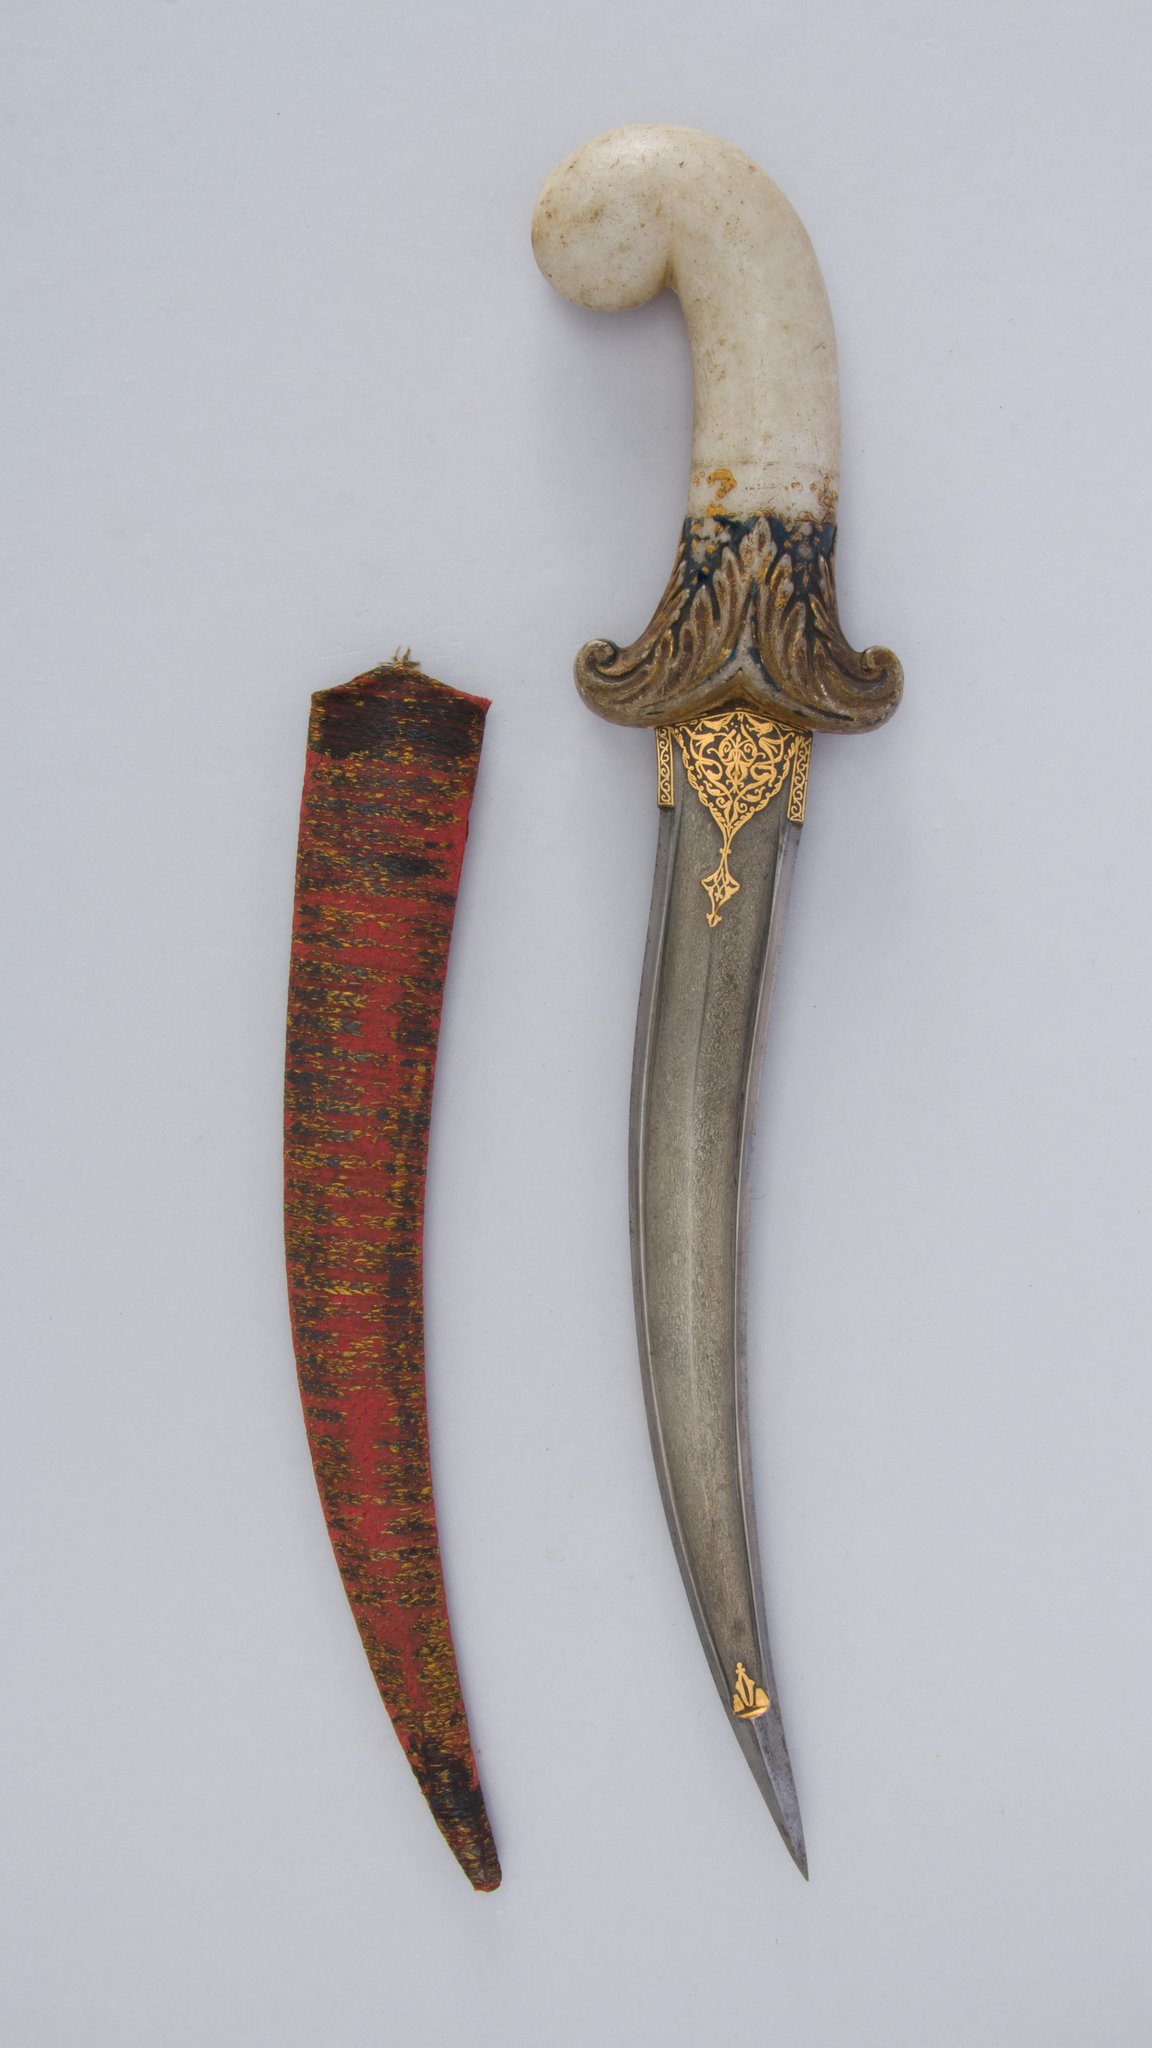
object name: dagger jambiya with sheath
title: Dagger (Jambiya) with Sheath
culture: indian, mughal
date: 1801-1900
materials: gold, marble, silk, silver, steel, wood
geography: india